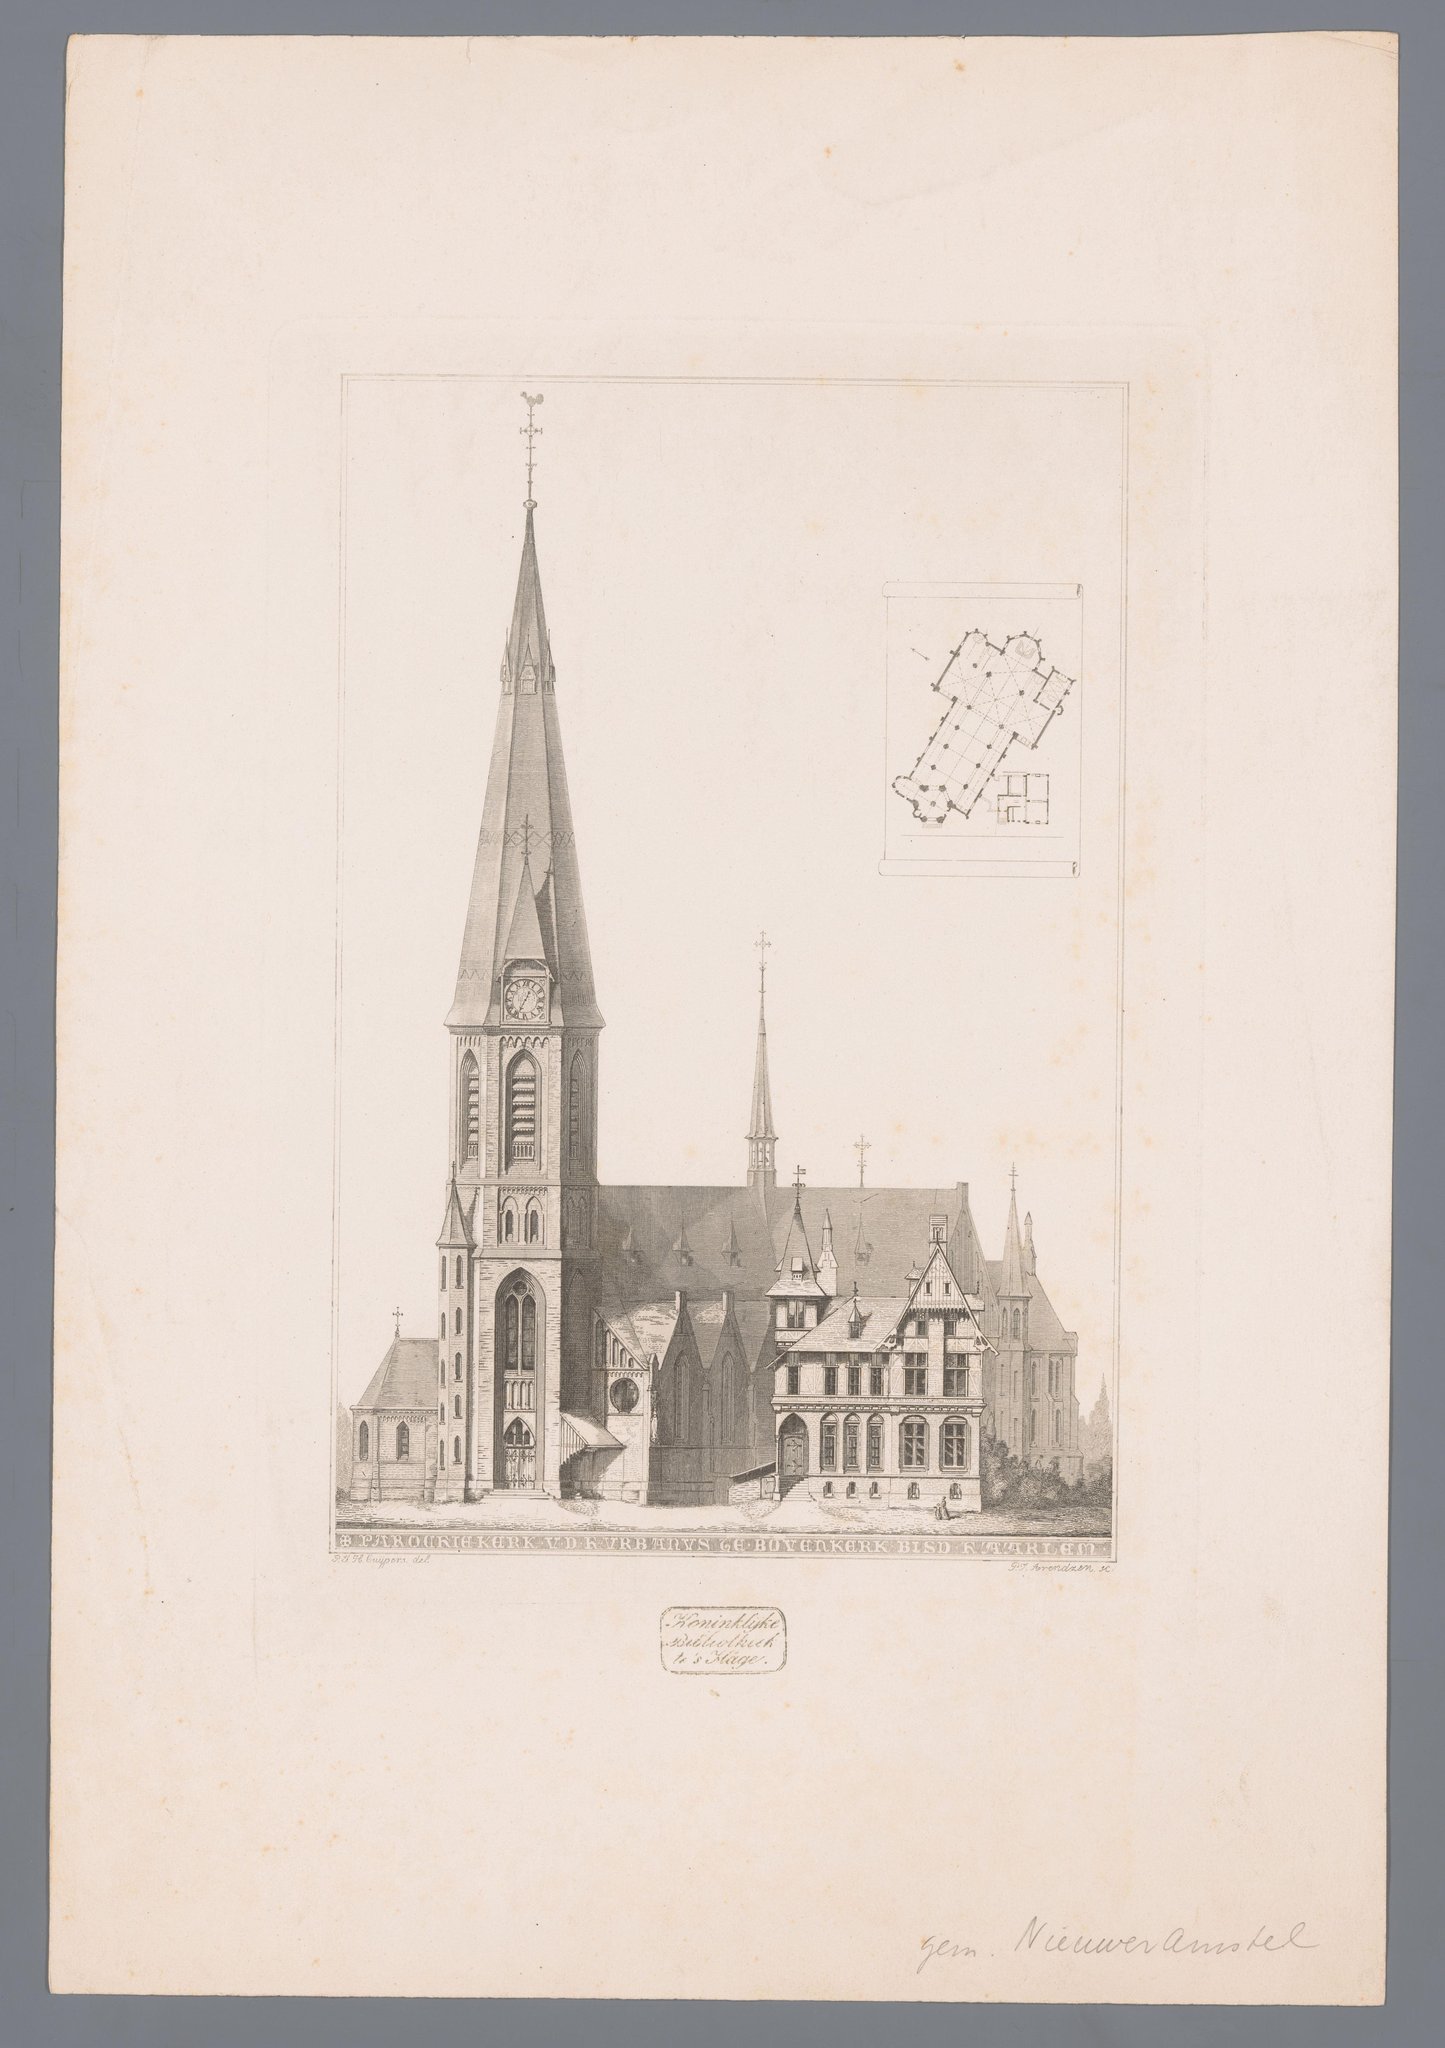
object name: print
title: Sint-Urbanuskerk te Haarlem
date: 1856-1932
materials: paper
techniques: engraving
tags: church (exterior)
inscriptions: stamp: ‘Koninklijke Bibliotheek te 's Hage’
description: Gezicht op de Sint-Urbanuskerk te Haarlem, ook wel Bovenkerk genoemd. Rechts een plattegrond van de kerk.